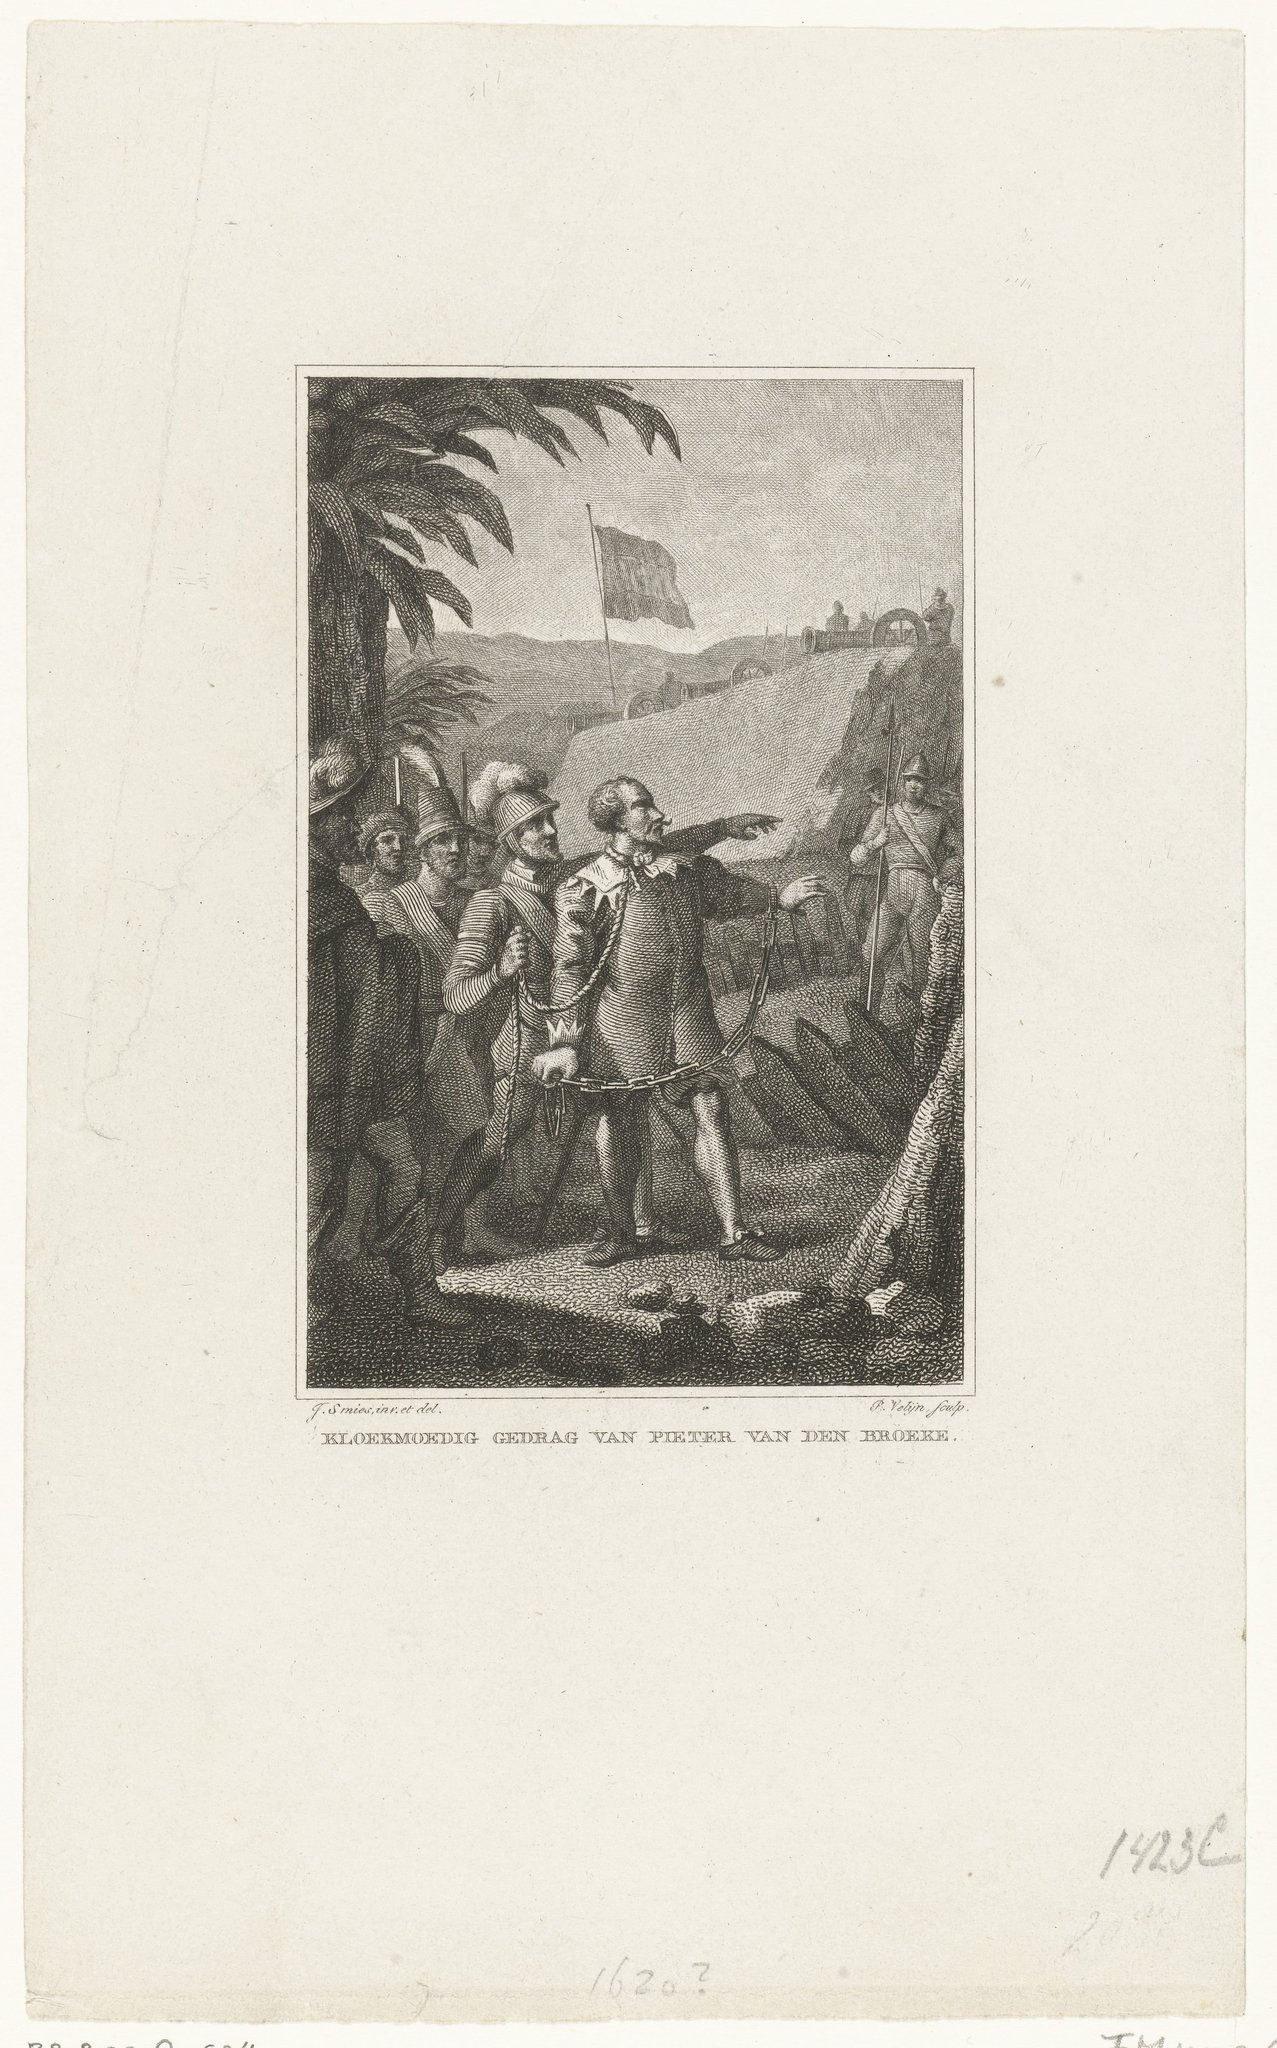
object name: print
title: Heldendaad van Pieter van den Broecke, 1620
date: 1823-1829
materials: paper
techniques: engraving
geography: netherlands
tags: antwerp, pieter van den broecke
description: Gebruikt als illustratie in: P.G. Witsen Geysbeek en G. Engelberts Gerrits, Schoonheden en merkwaardige tafereelen uit de Nederlandsche geschiedenis. G. Portielje, Amsterdam 1825-1829, 8 delen. Dit nummer is een door het RPK toegevoegd nummer en staat niet in Frederik Muller, het werk waar de prent voor is gemaakt of uit afkomstig is, staat wel vermeld in Frederik Muller.